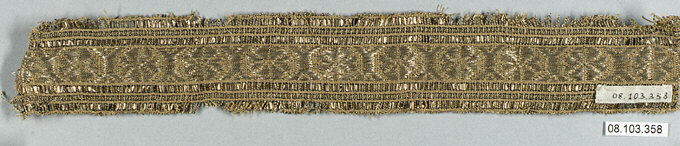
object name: galloon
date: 1601-1800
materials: metal thread, silk